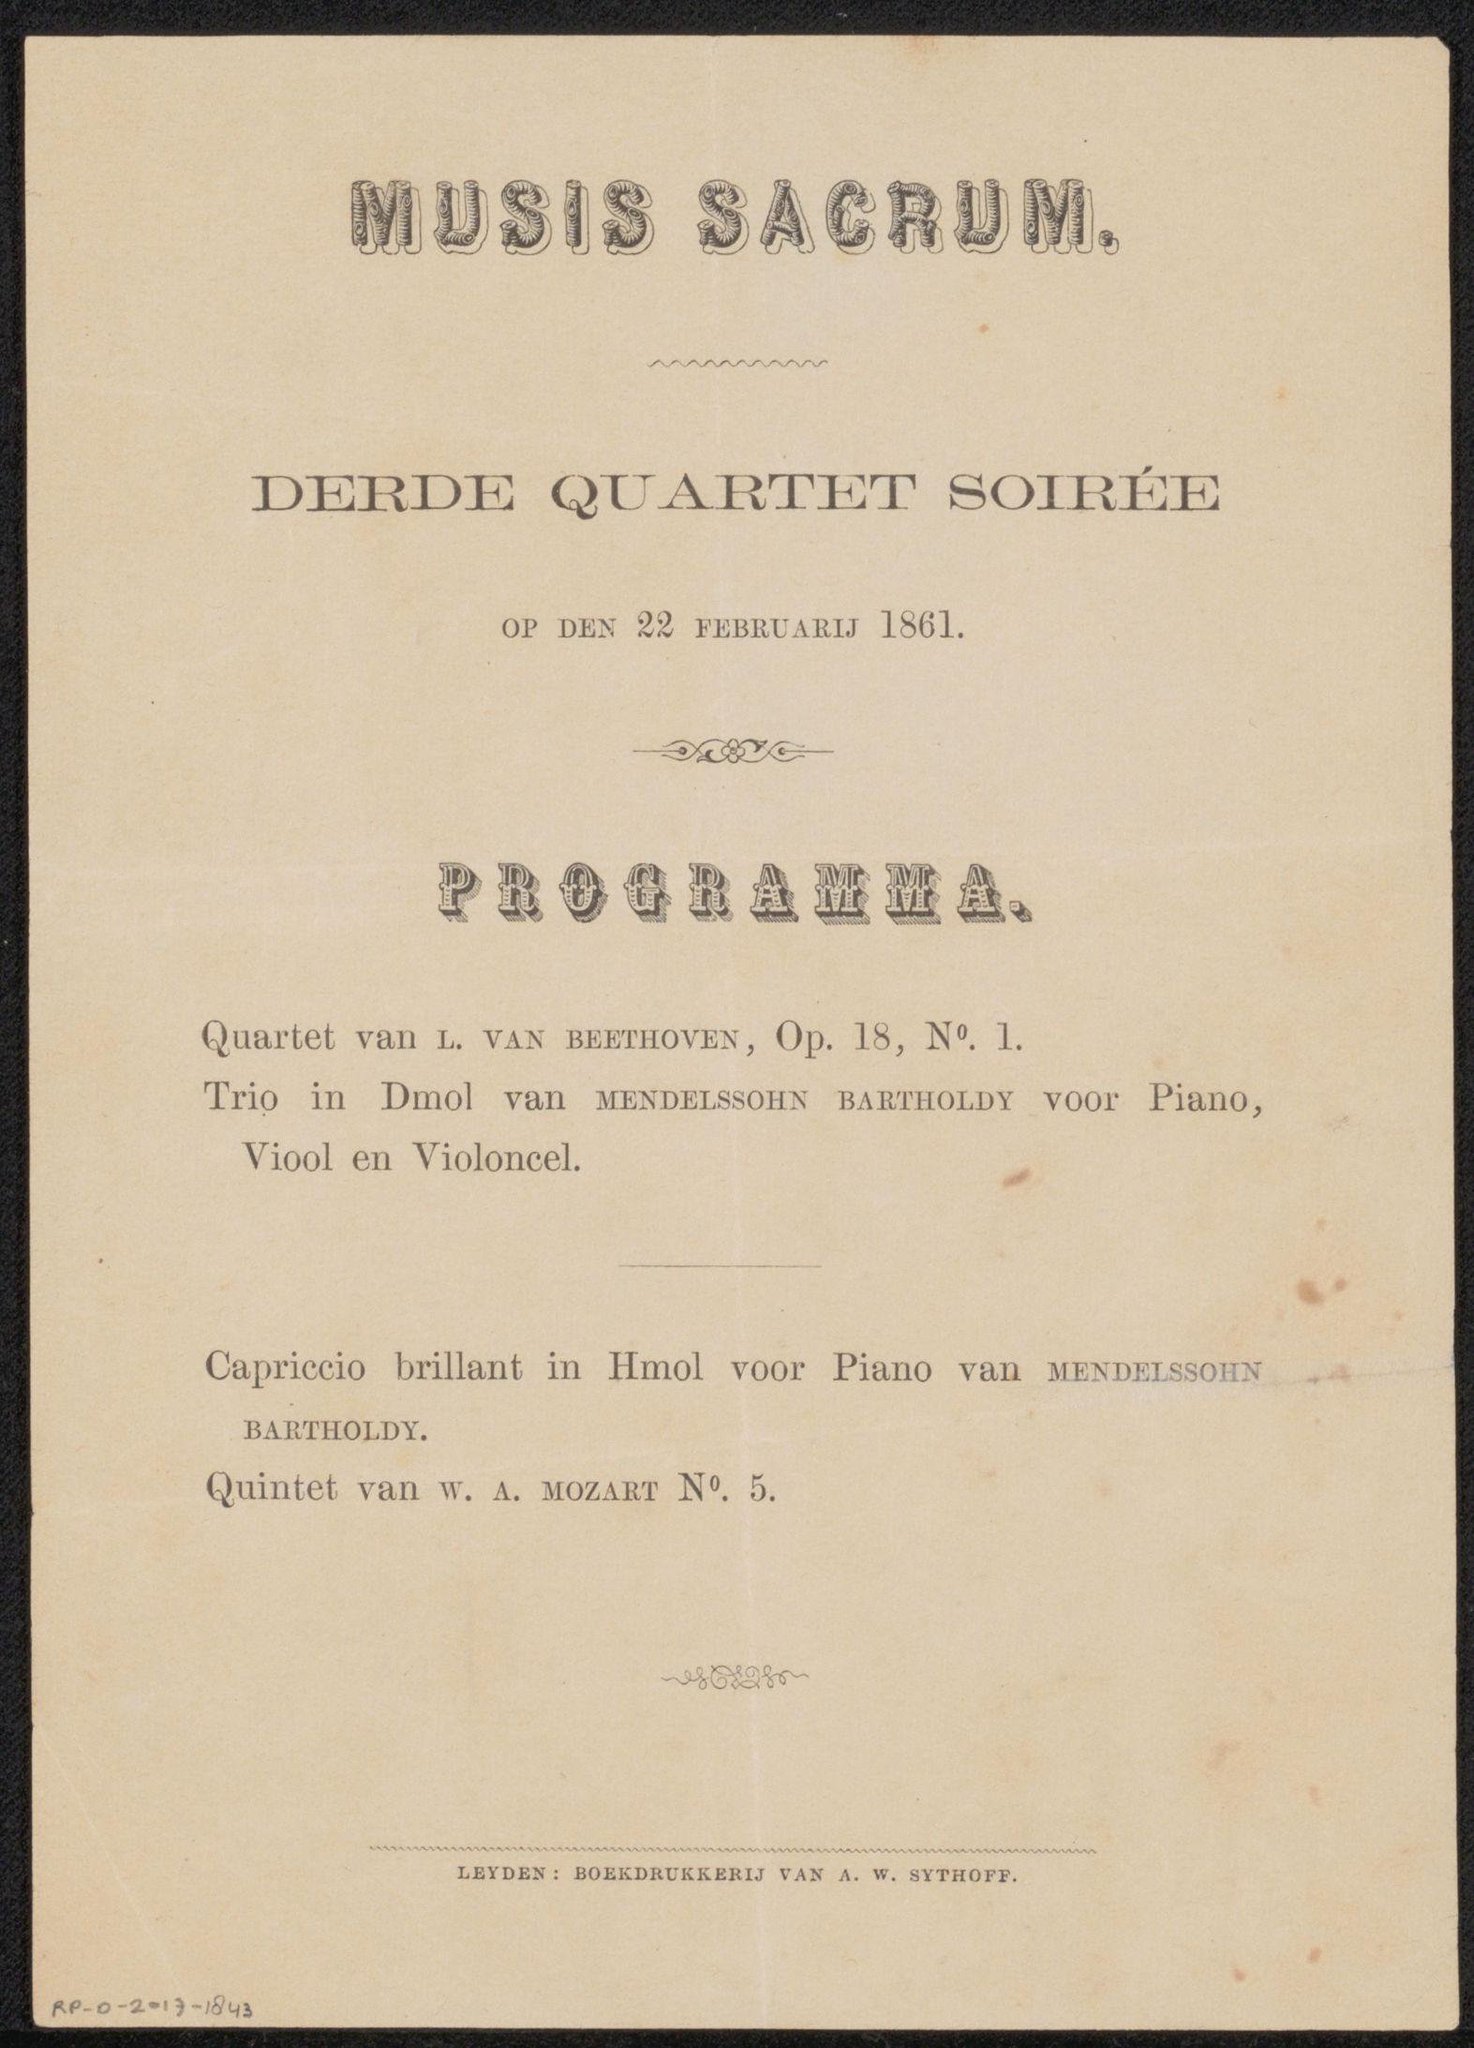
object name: aantekening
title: Aantekening betreffende Karel Elias van Toulon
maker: pieter otto van der chijs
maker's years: 1802-1867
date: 1852-1867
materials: ink, paper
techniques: pen, writing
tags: haarlem, draughtsman, karel elias van toulon, drawing, music, family life, travelling; tourism, education, tuition of the artist (in general)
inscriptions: collector's mark: Lugt 2233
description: Brief is geschreven op verso van een gedrukte aankondiging.